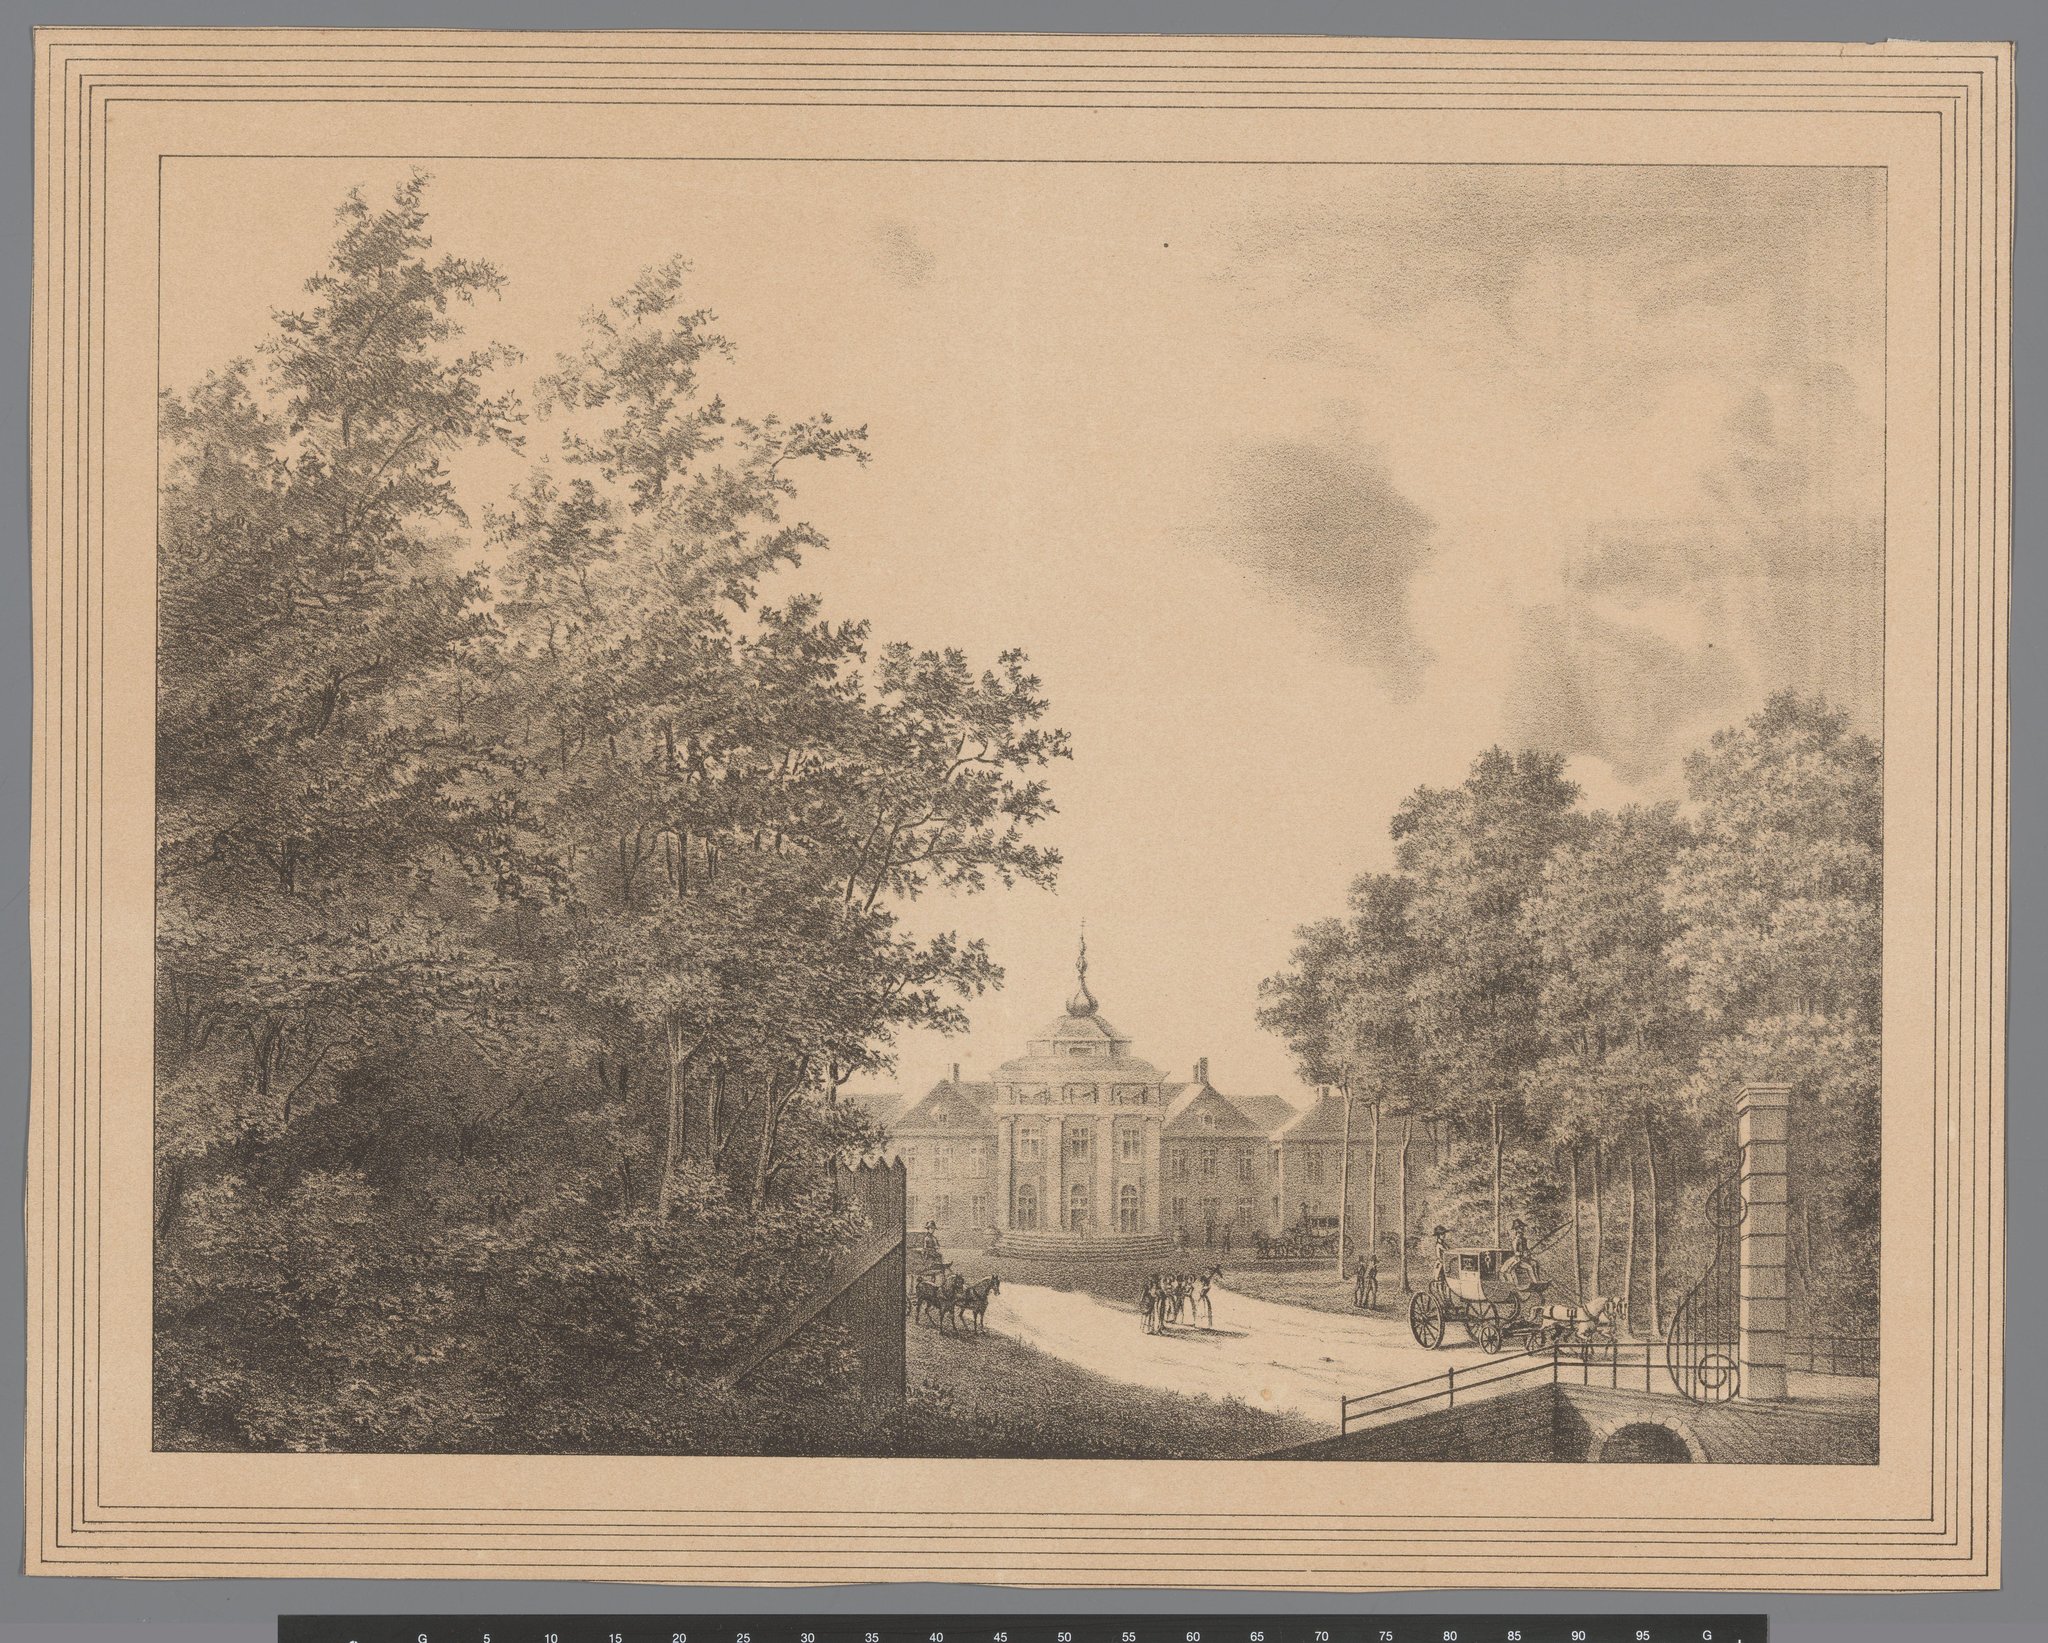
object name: print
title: Huis ten Bosch in Den Haag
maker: Anonymous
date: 1825-1875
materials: paper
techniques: lithograph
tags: palace, the hague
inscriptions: collector's mark: Lugt 2228